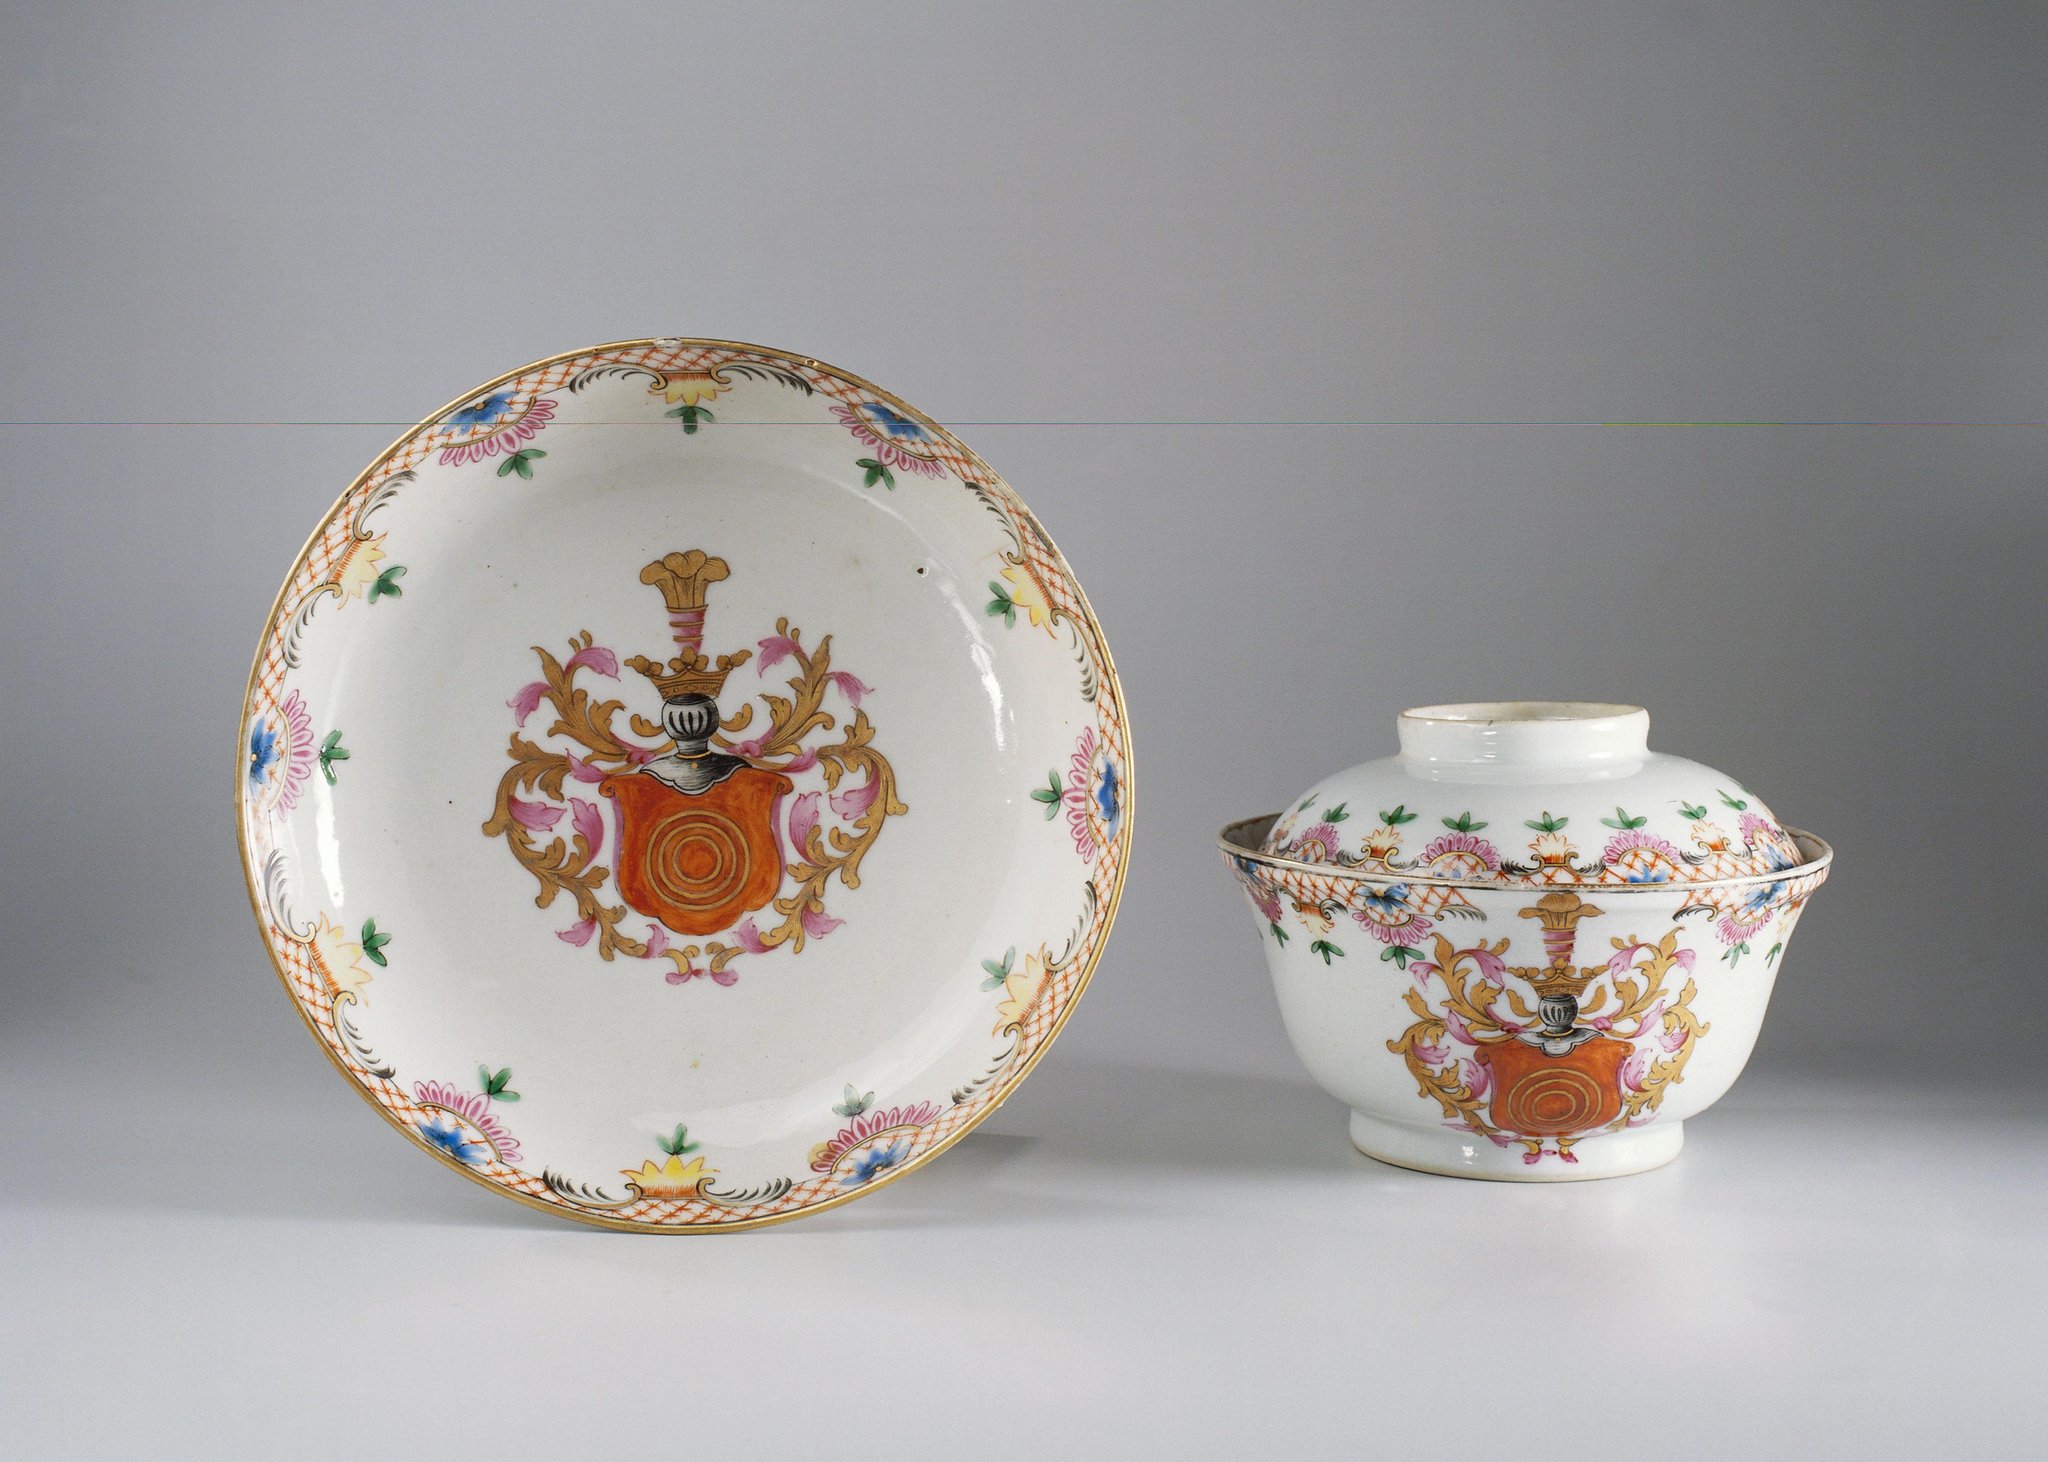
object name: sugar box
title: Sugarbowl with the arms of the Romswinckel family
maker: Anonymous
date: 1765-1770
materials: glaze, gold, paint, porcelain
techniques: firing, gilding, turning, vitrification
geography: china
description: Suikerpot van porselein, beschilderd op het glazuur in blauw, rood, roze, groen, geel, zwart en goud. Op de wand het wapen van de familie Romswinckel. Het wapen heeft een rode achtergrond met drie concentrische gouden ringen. Het helmteken is een kroon met daarboven drie ringen en pluimen. Het dekkleed bestaat uit bladranken. Op de binnenrand een decoratieve band met traliewerk en bladranken met gestileerde bloemen. Een barst en een chip in de rand van de pot. Wapenporselein met emailkleuren.